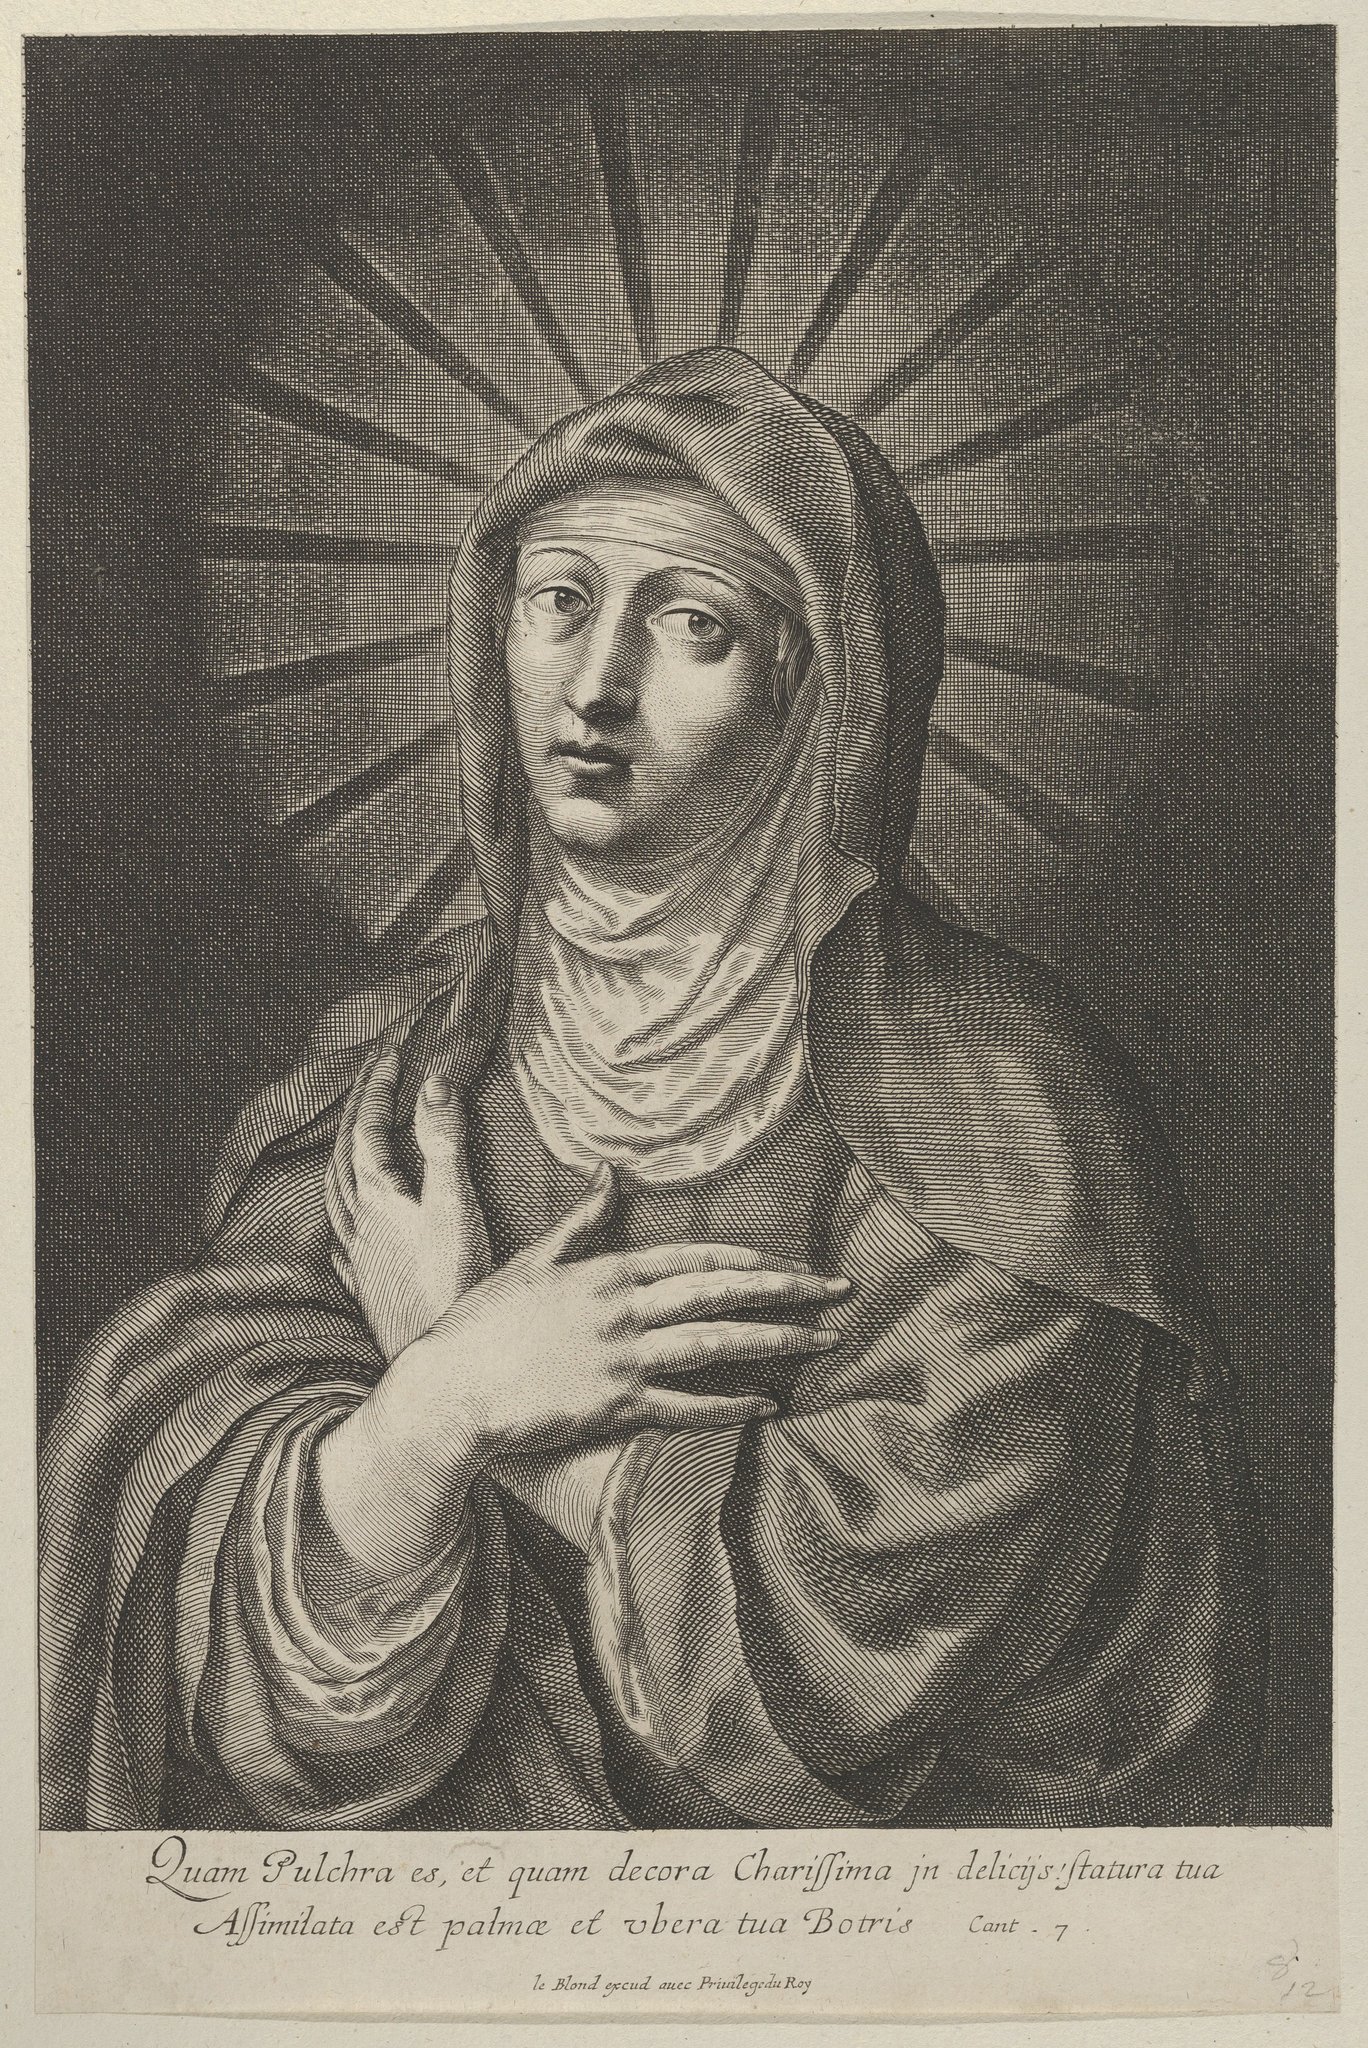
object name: print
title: The Savior with the Globe in his Hand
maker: grégoire huret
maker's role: artist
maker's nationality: french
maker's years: 1606-1670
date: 1601-1700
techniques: engraving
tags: virgin mary